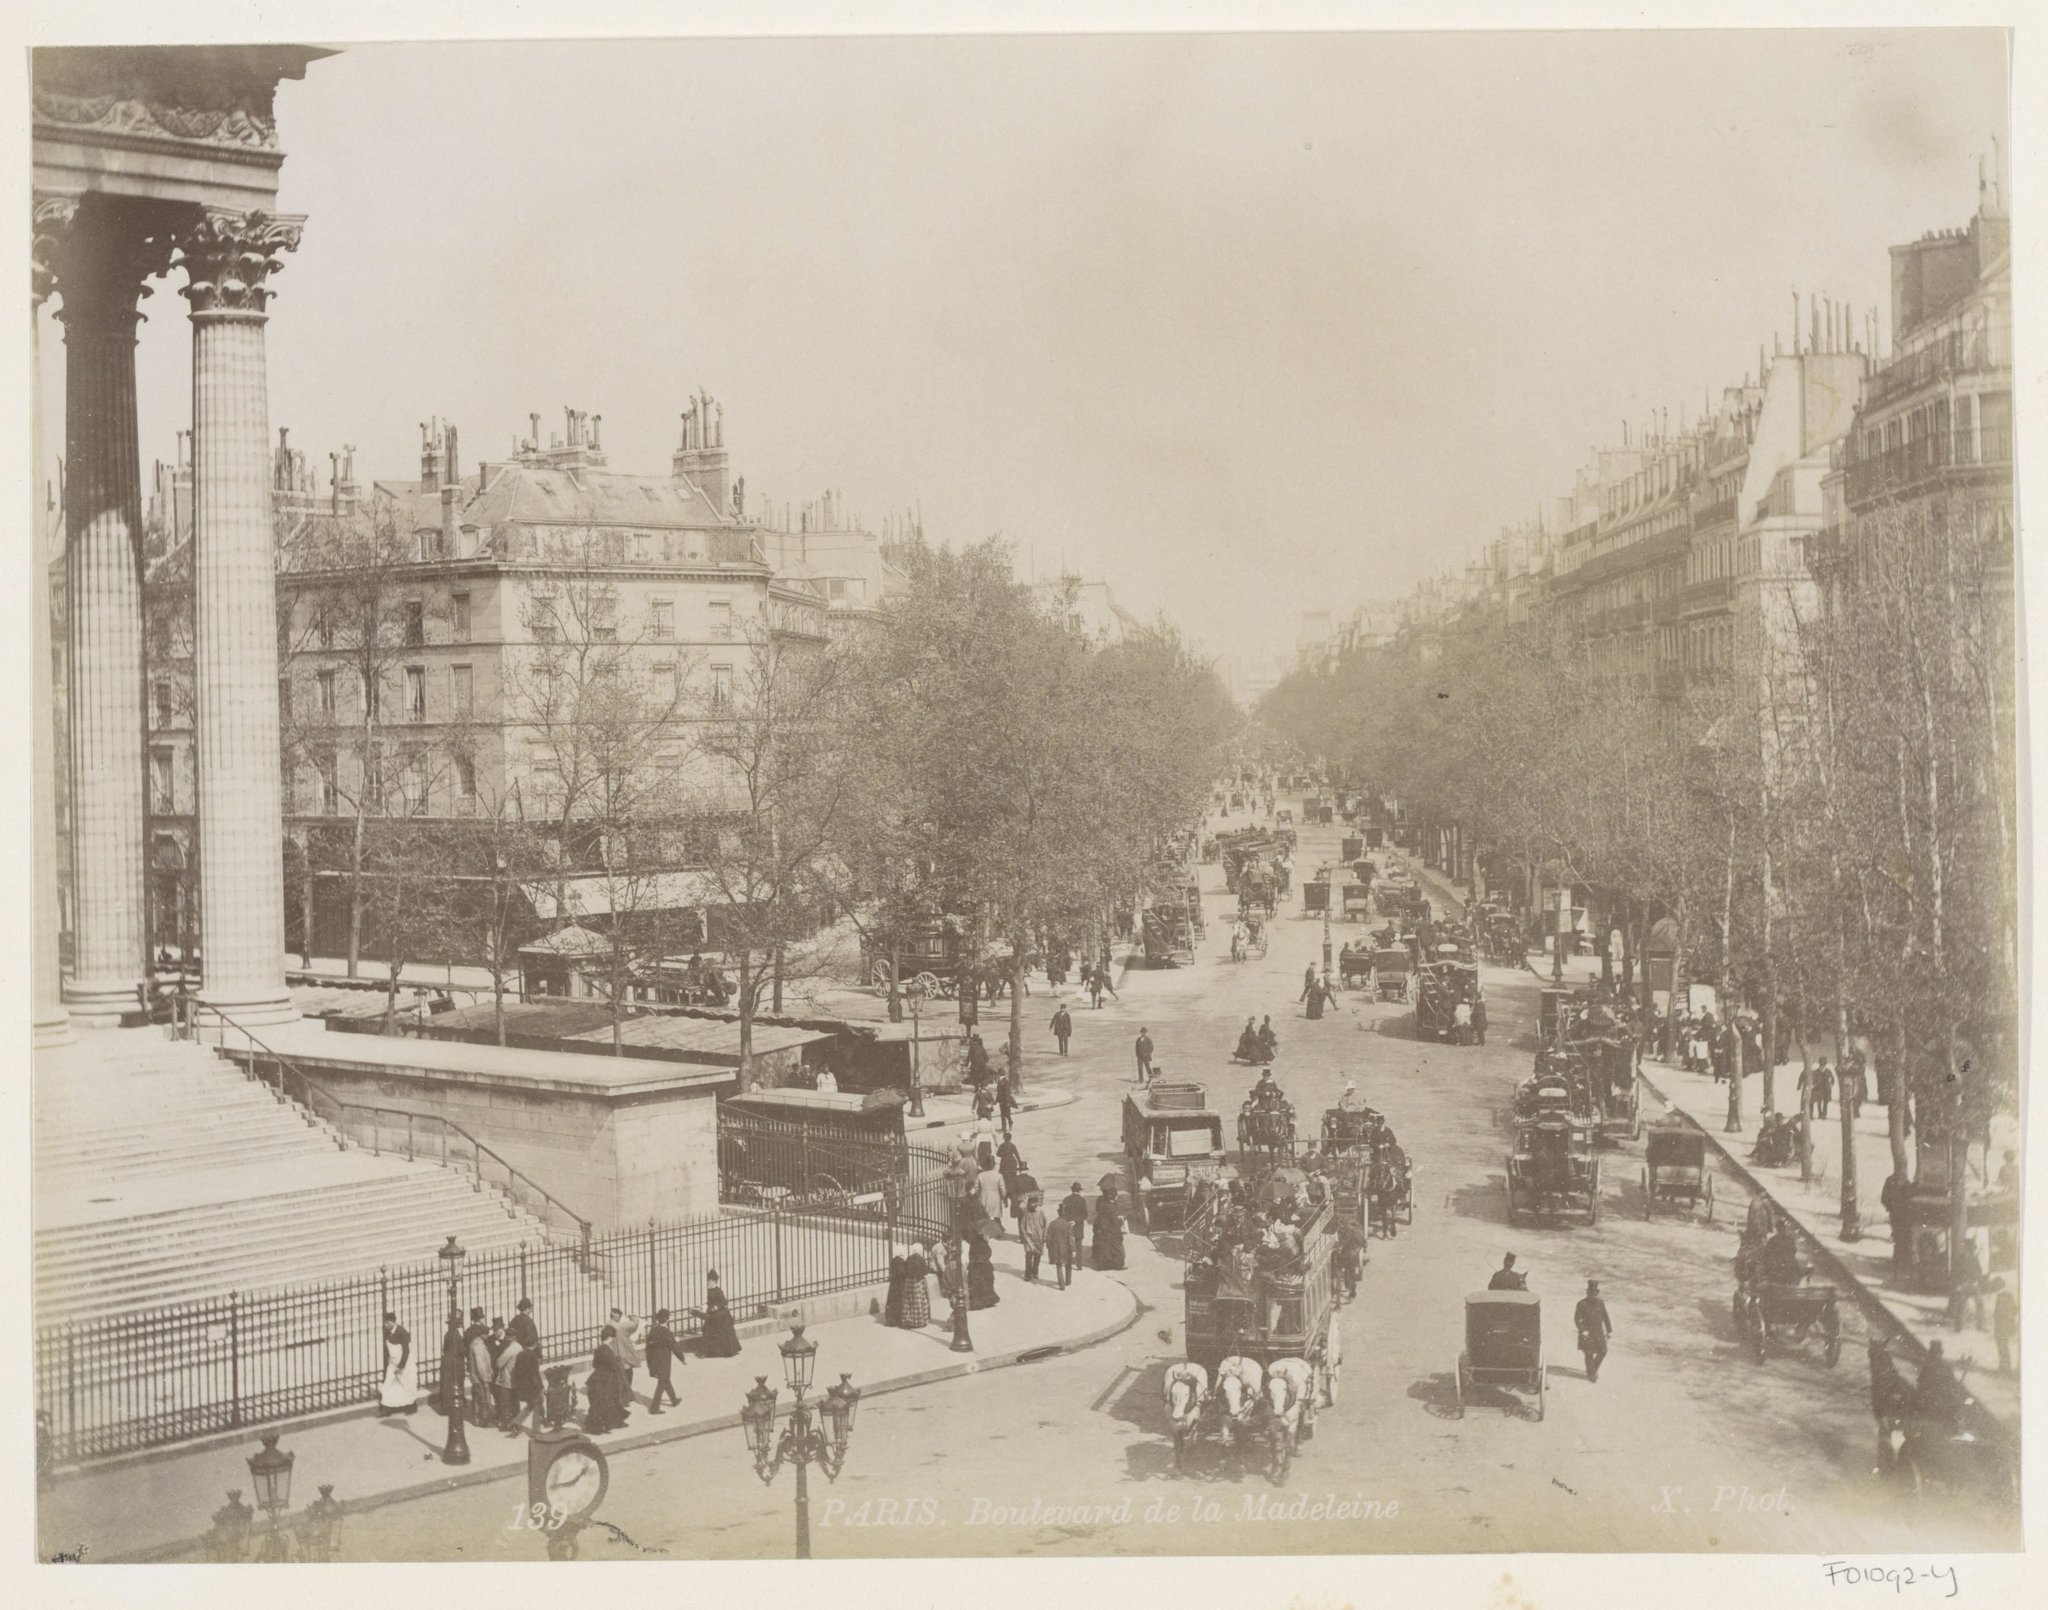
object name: photograph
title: Boulevard de la Madeleine in Parijs met voorbijgangers, paardenkoetsen en een paardentram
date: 1880-1900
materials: cardboard, paper, photographic support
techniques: albumen print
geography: paris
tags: diligence, omnibus, horse-tram, four-wheeled, animal-drawn vehicle, e.g.: cab, carriage, coach, street (+ city(-scape) with figures, staffage)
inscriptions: negative number: ‘139’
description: Onderdeel van Reisalbum met foto's van bezienswaardigheden in België en Frankrijk.